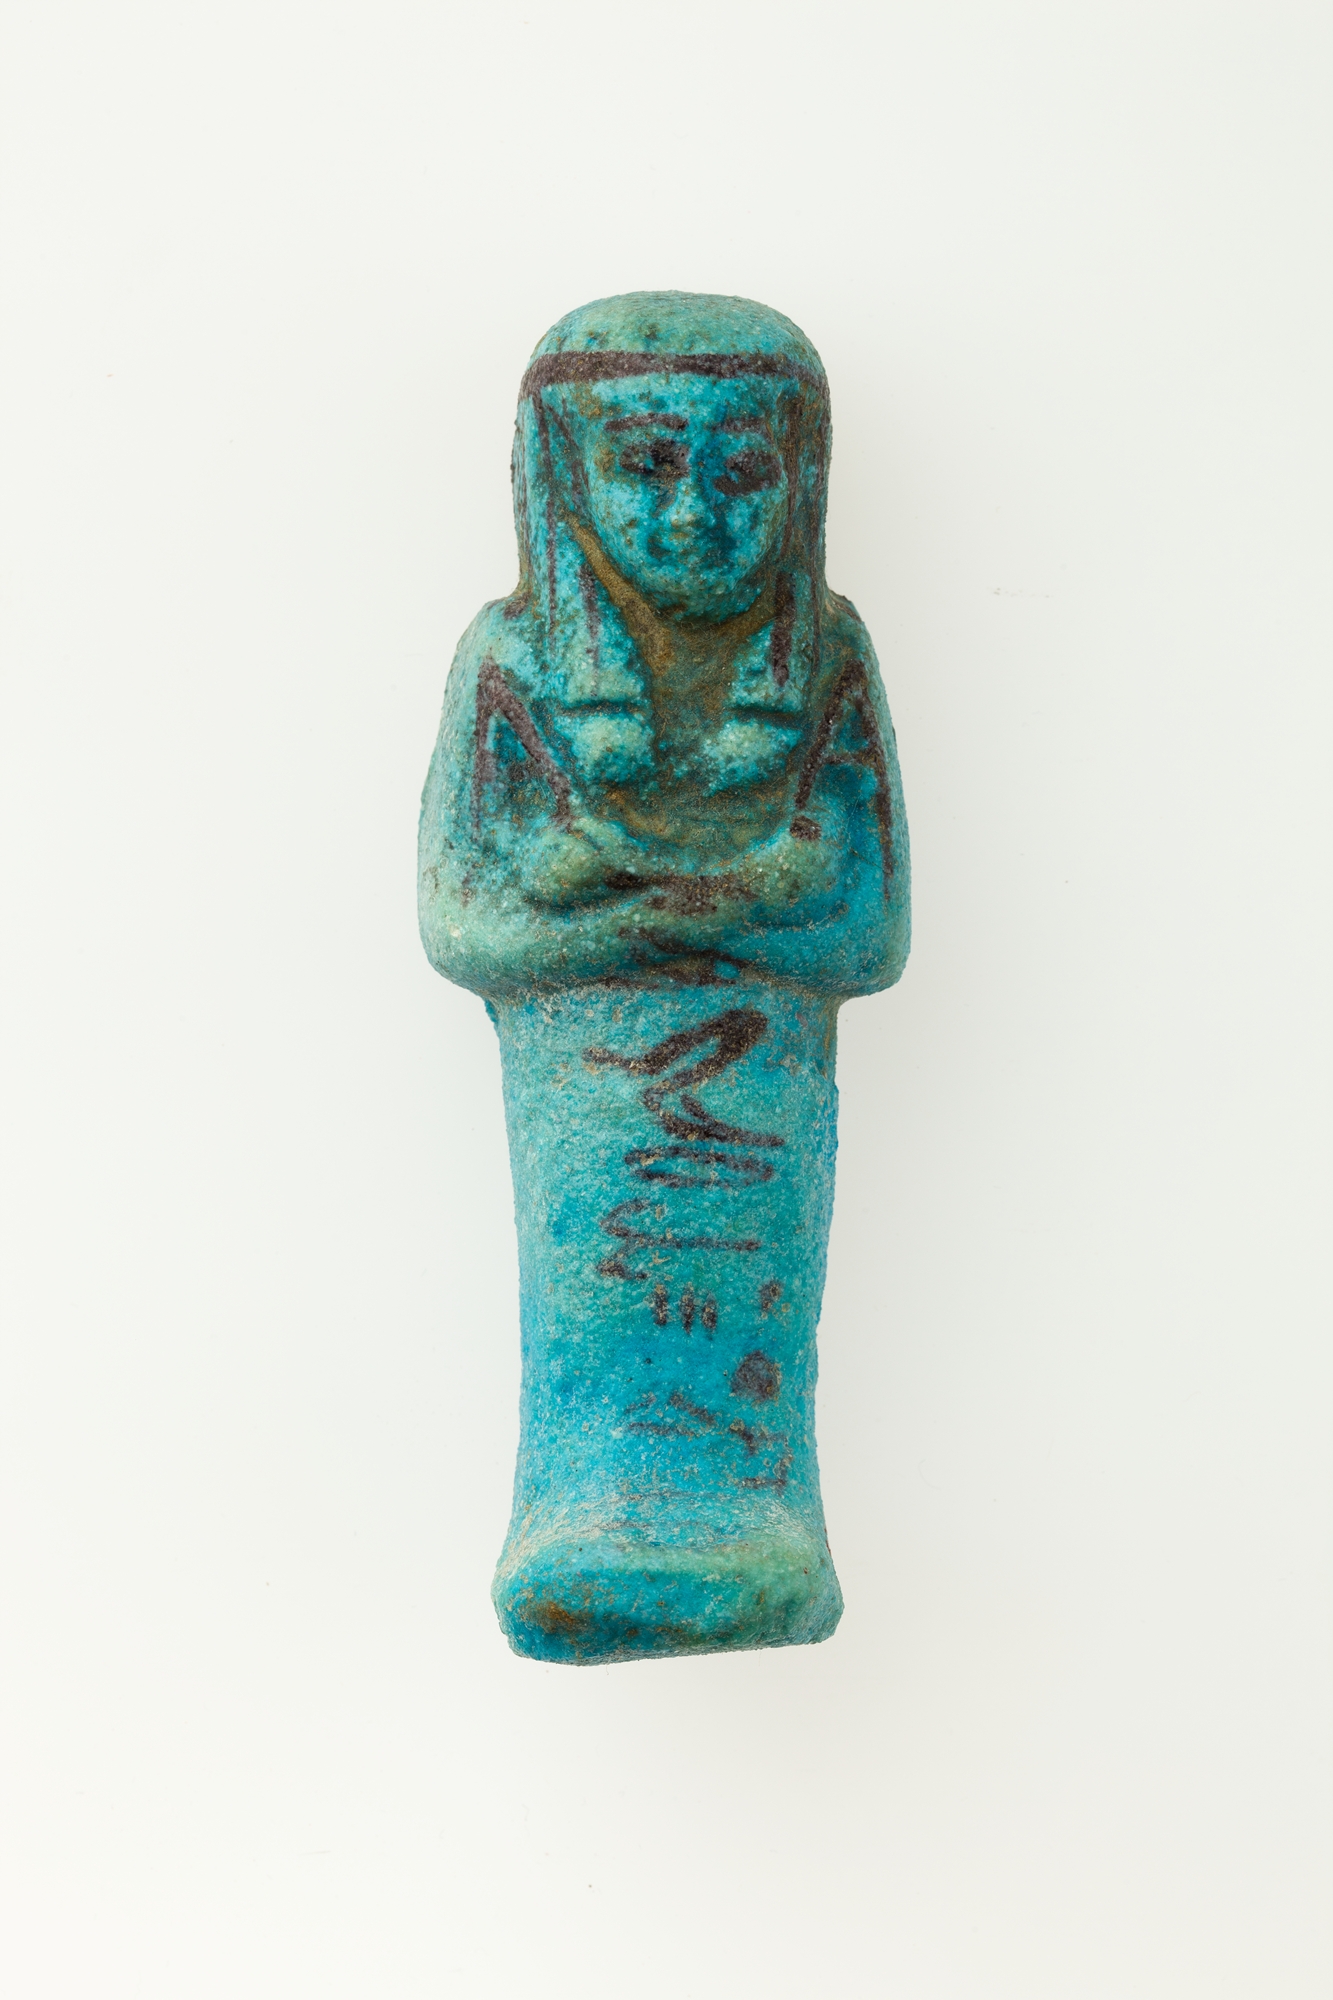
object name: shabti, henettawy c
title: Worker Shabti of Henettawy (C), Daughter of Isetemkheb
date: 990-970 BCE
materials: faience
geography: egypt